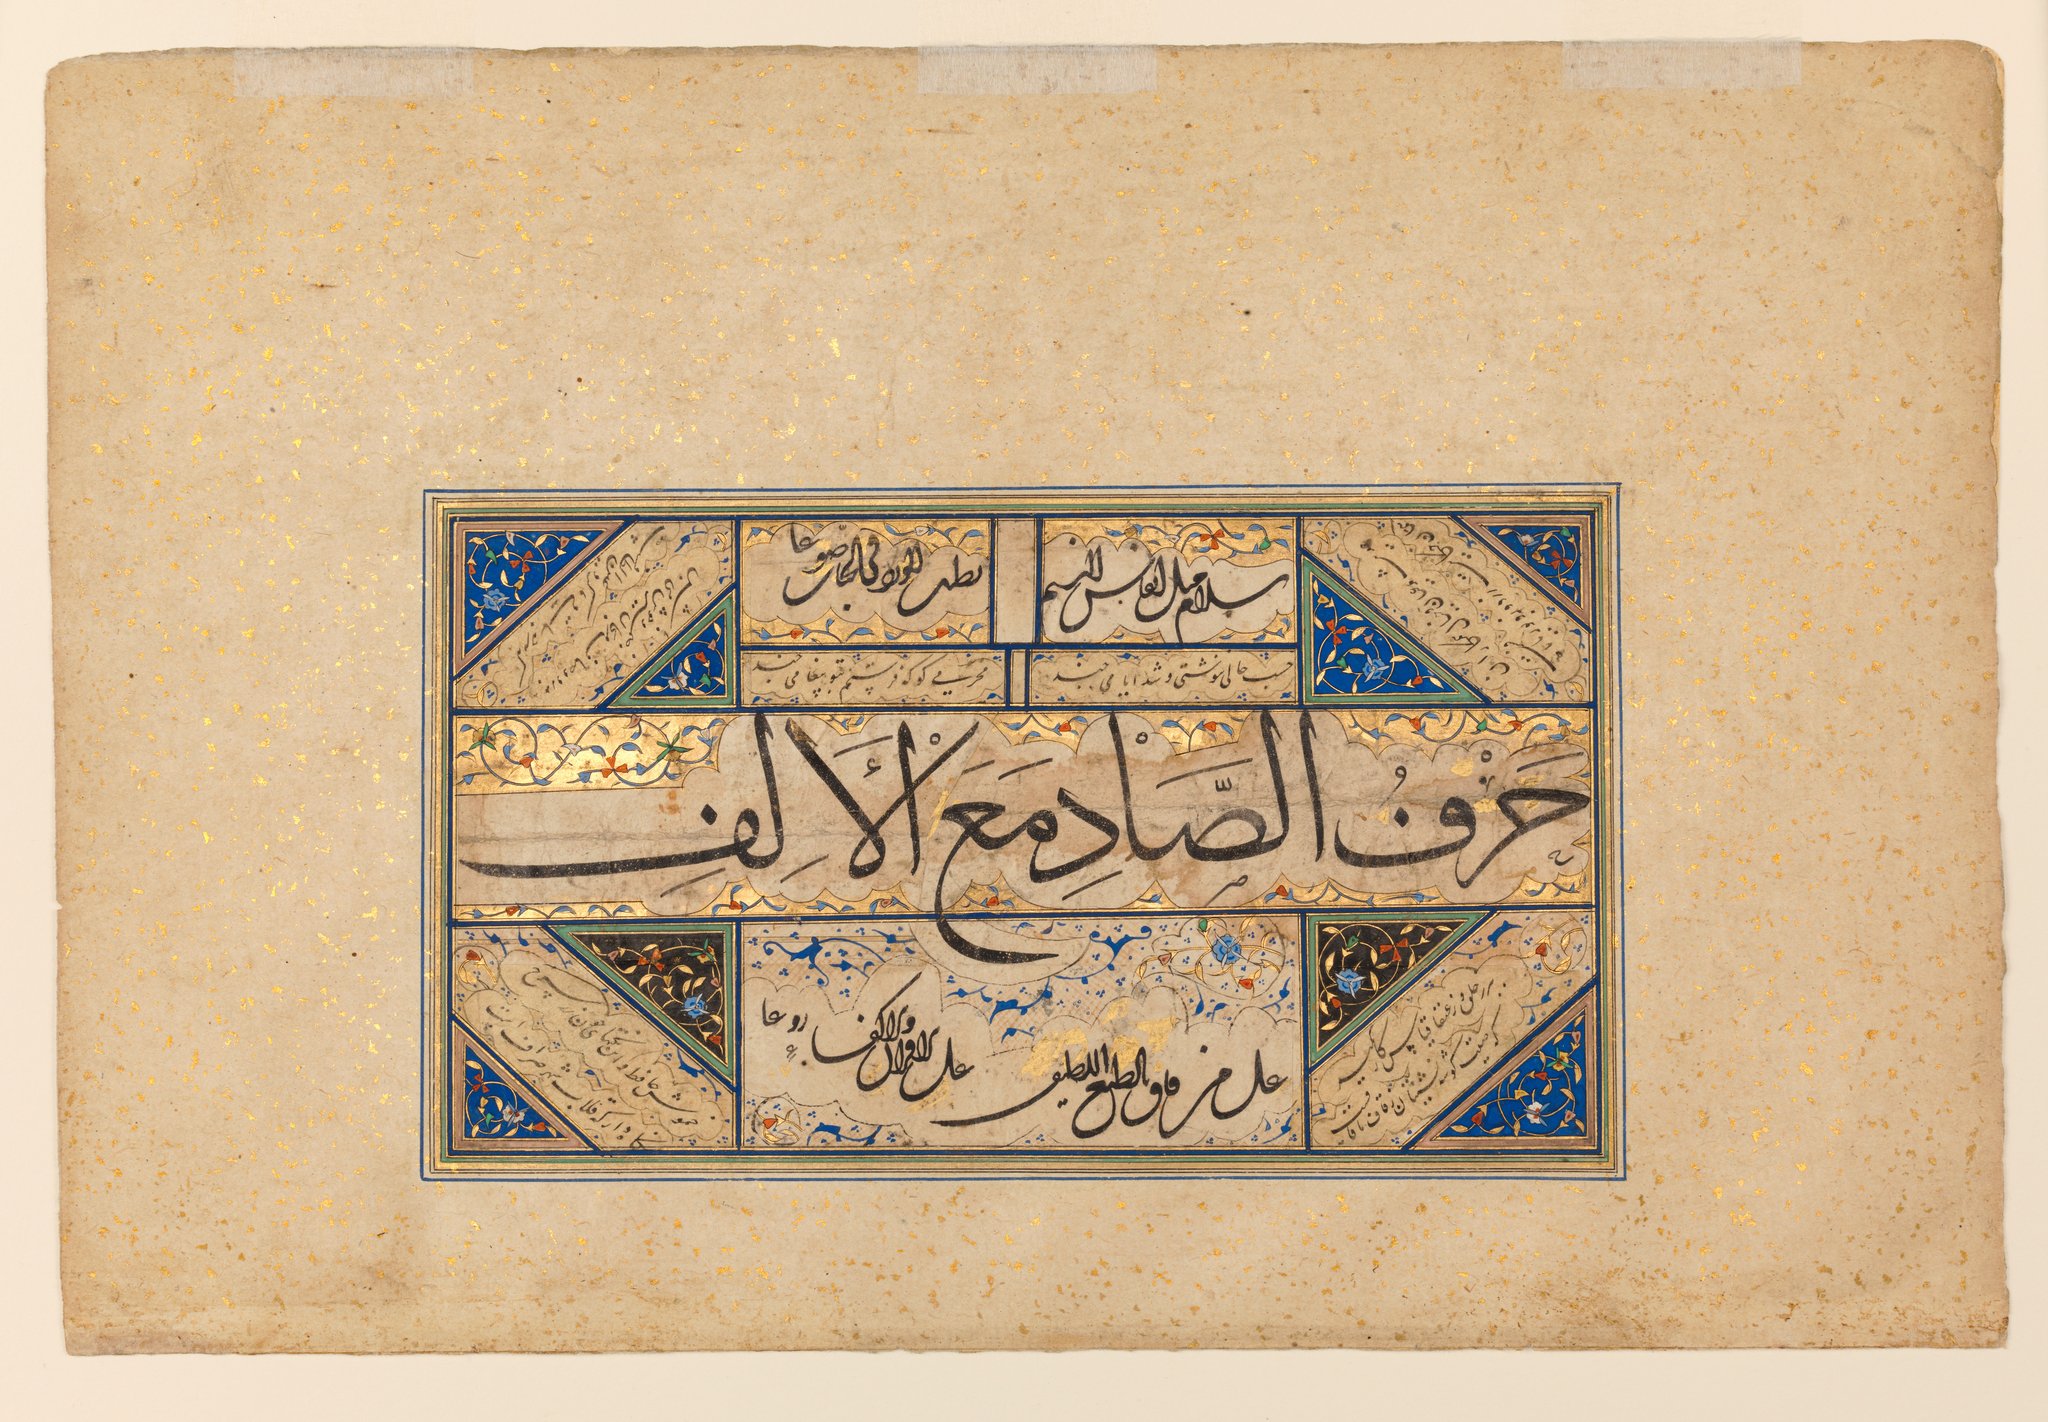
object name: non illustrated album leaf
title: Page of Calligraphy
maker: sultan muhammad nur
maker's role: calligrapher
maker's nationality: iranian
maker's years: 1448-1561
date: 1501-1533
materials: gold, ink, paper, watercolor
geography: iran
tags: poetry,calligraphy